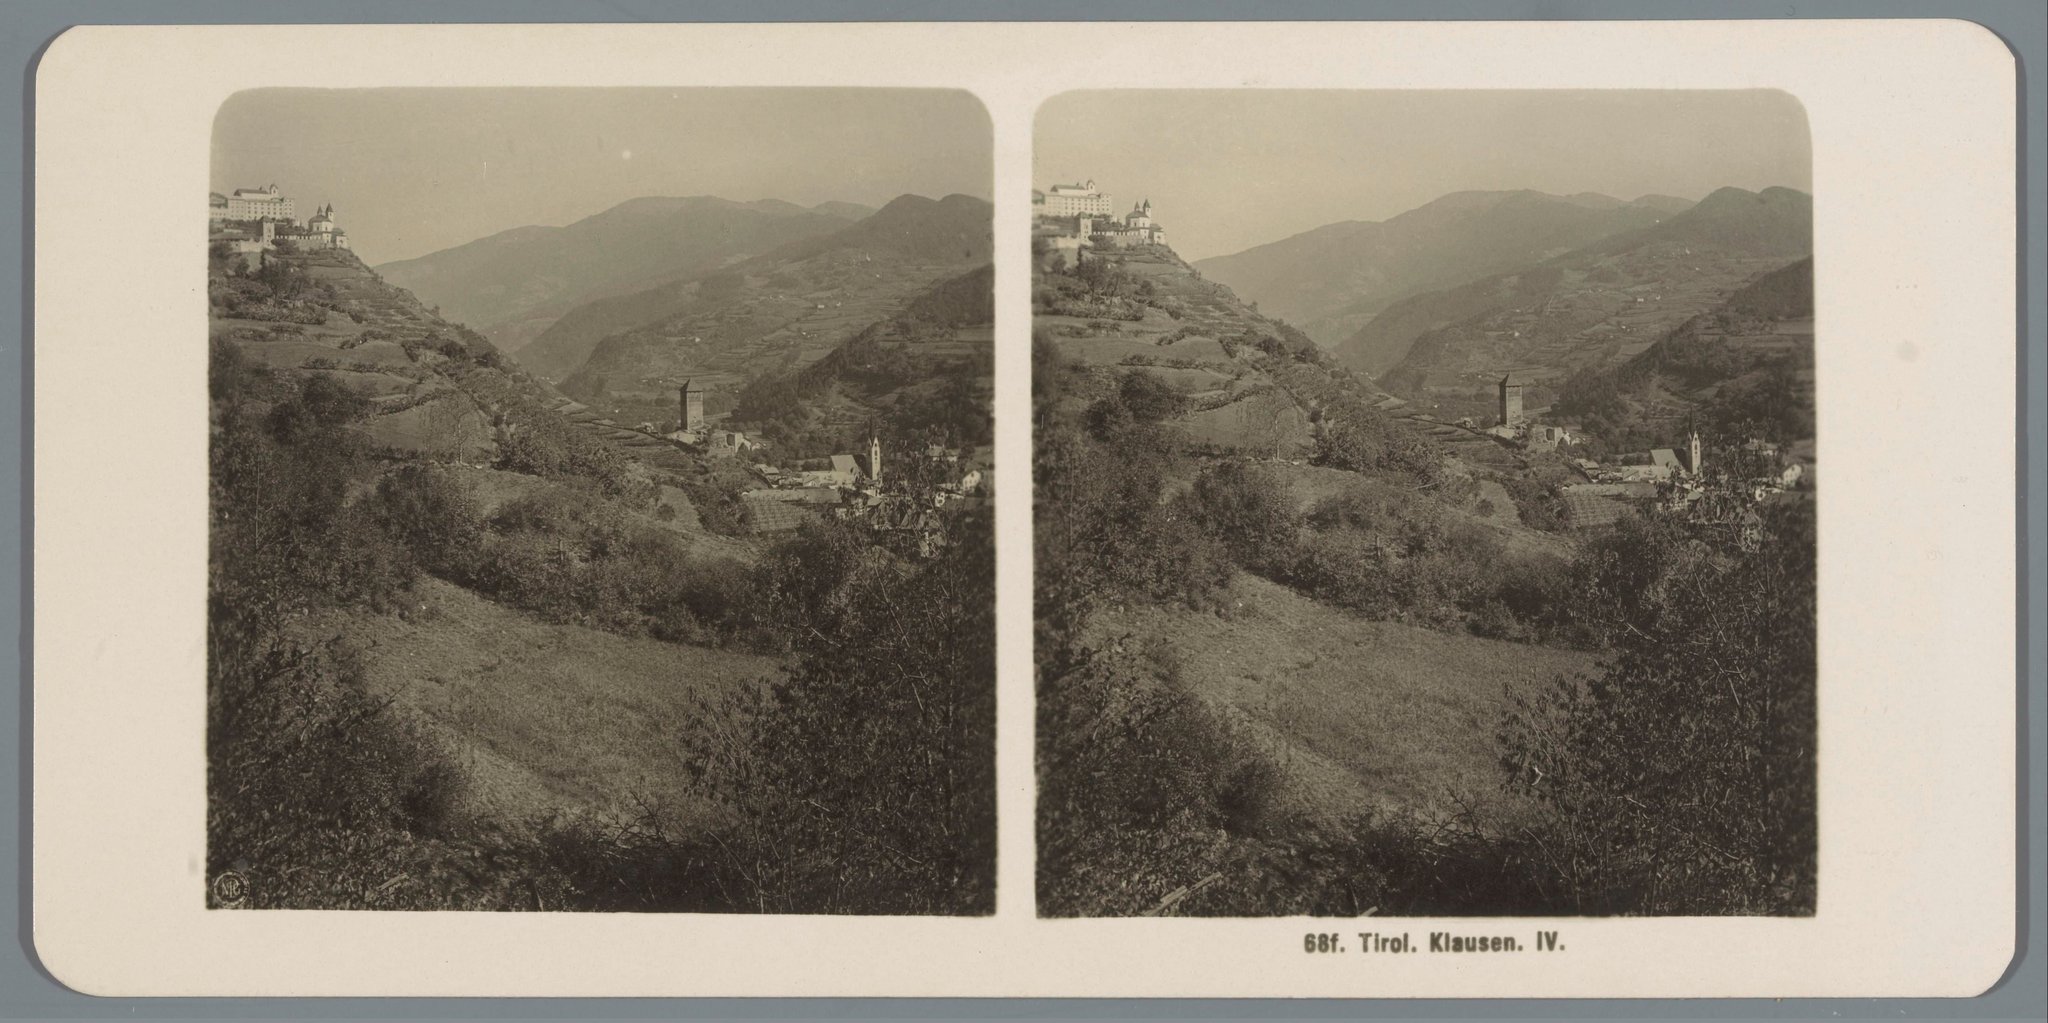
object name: stereograph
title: Tirol. Klausen. IV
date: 1900-1910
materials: cardboard, photographic support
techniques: gelatin silver print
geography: south tyrol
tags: city-view in general; 'veduta', mountains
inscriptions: inscription: ‘NPG’, number: ‘68f.’